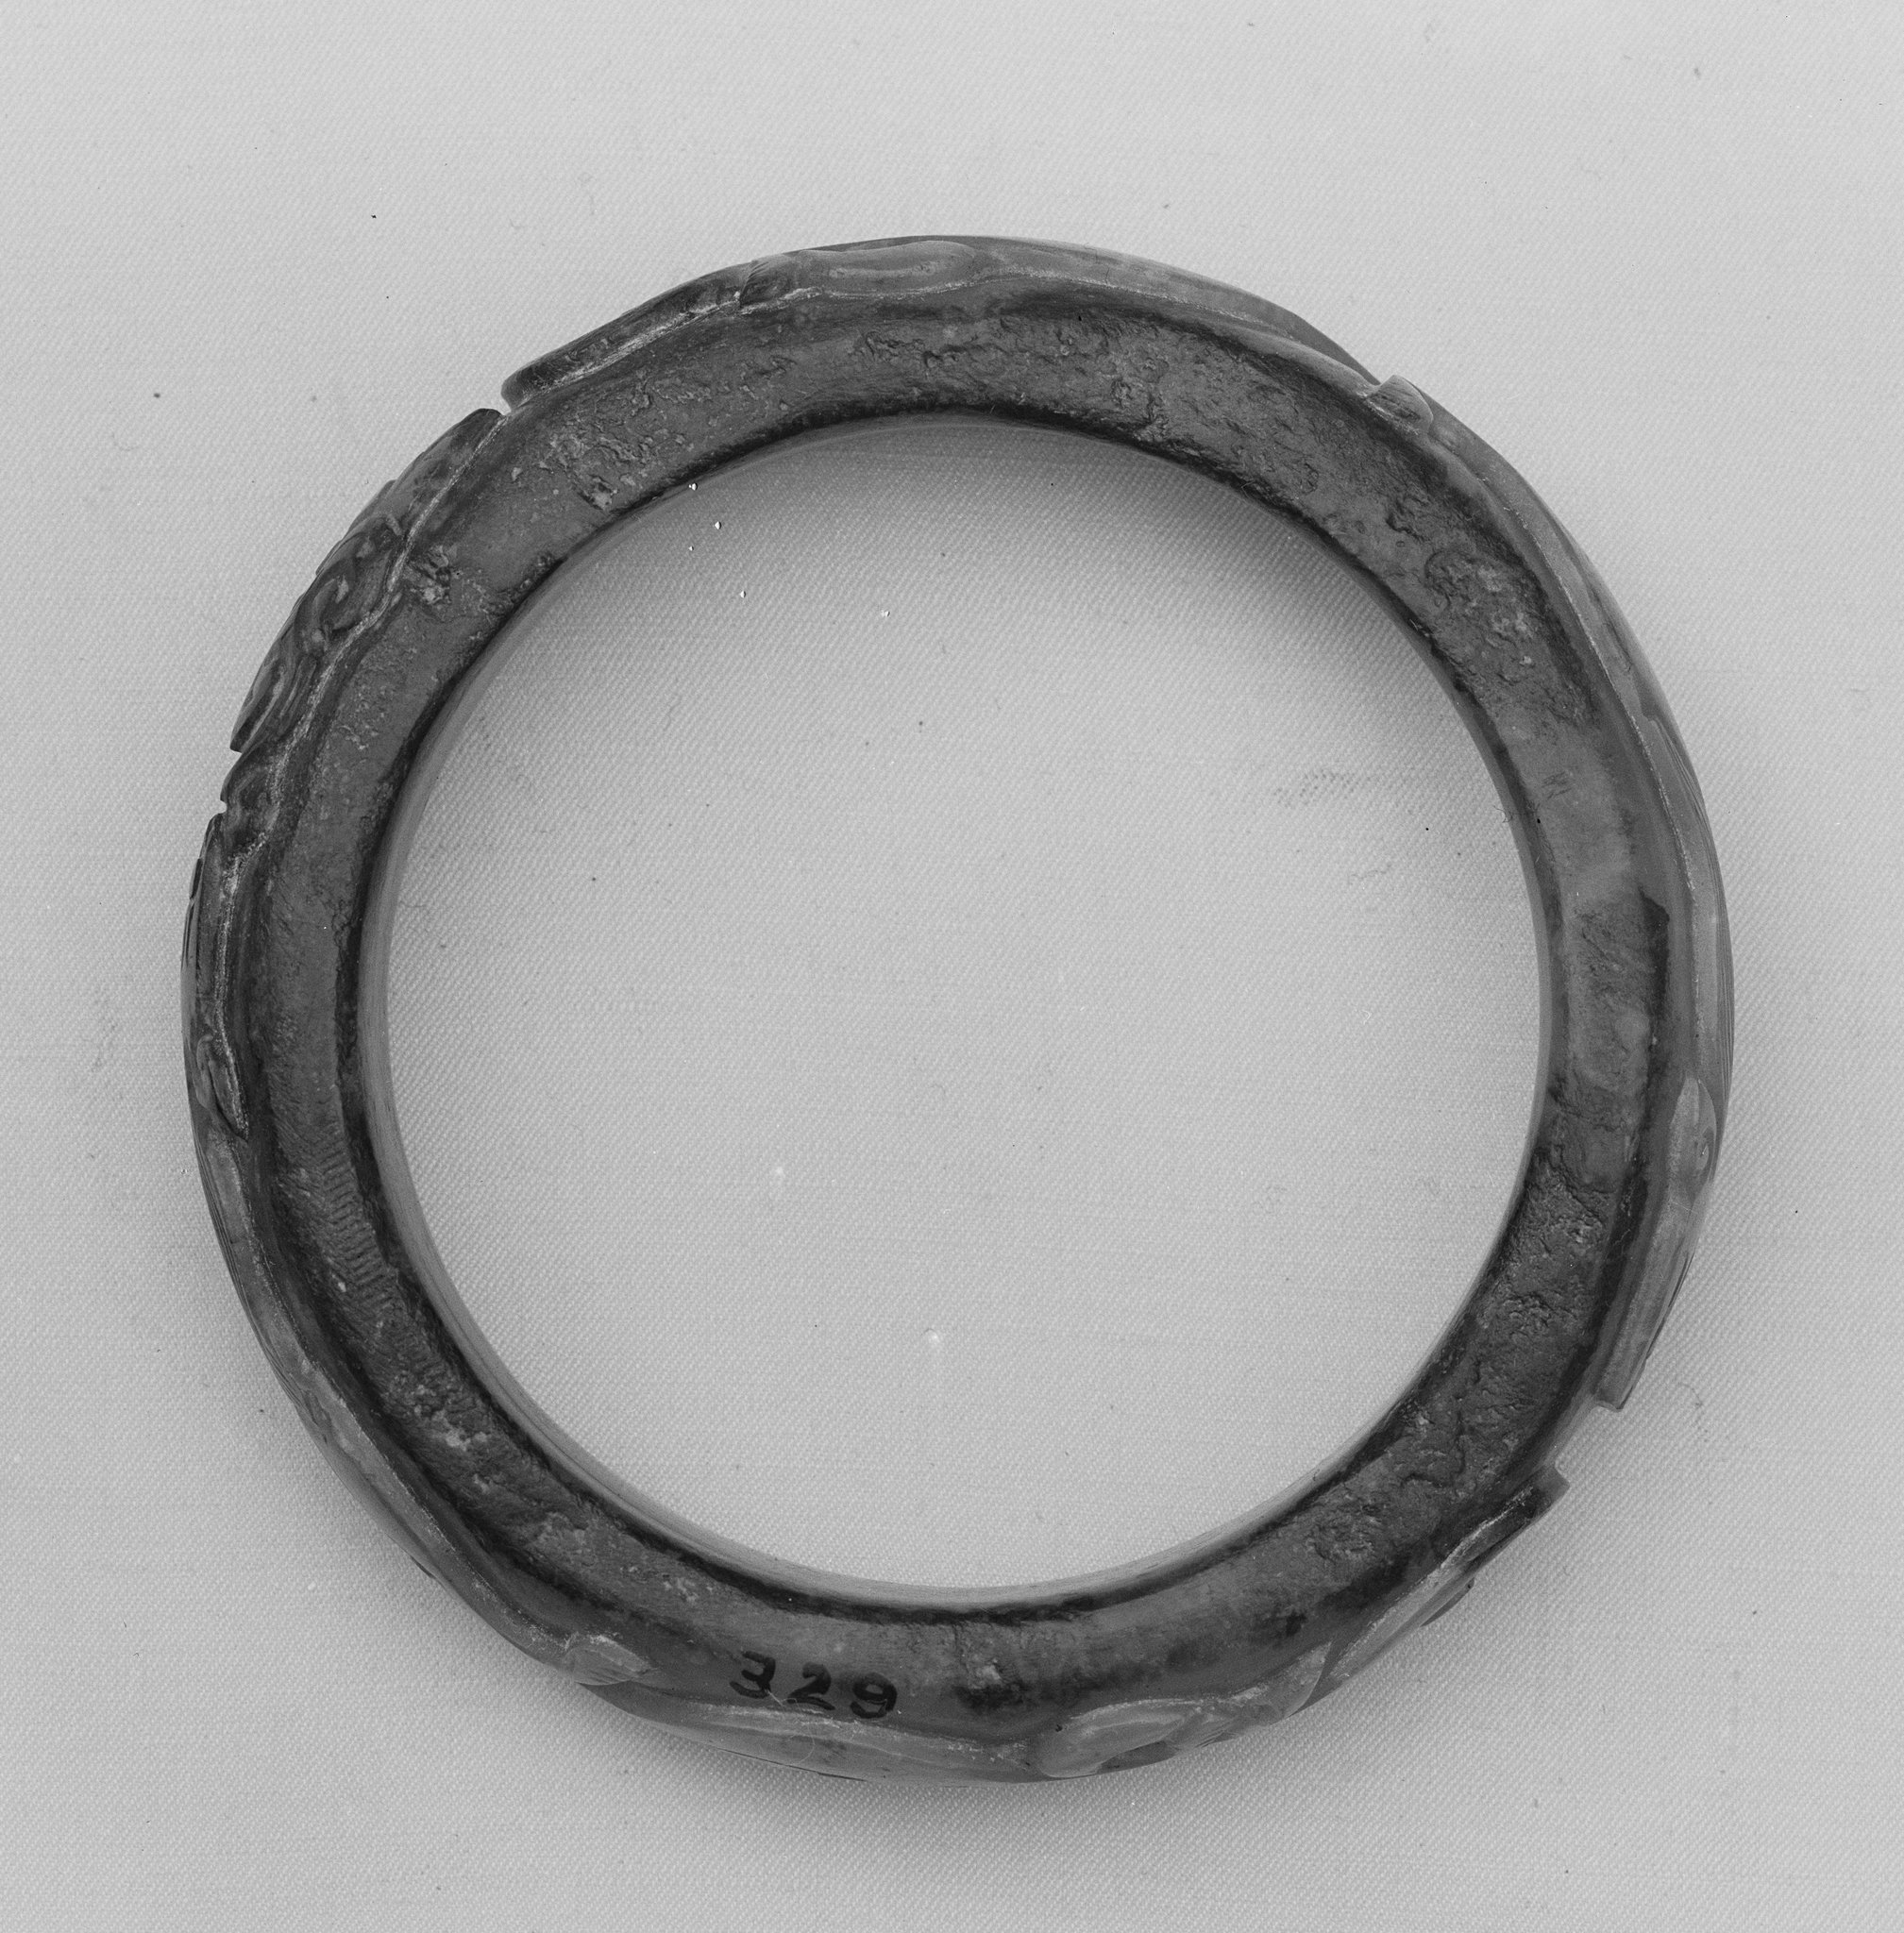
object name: armlet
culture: chinese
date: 206 BCE-220 CE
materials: jade